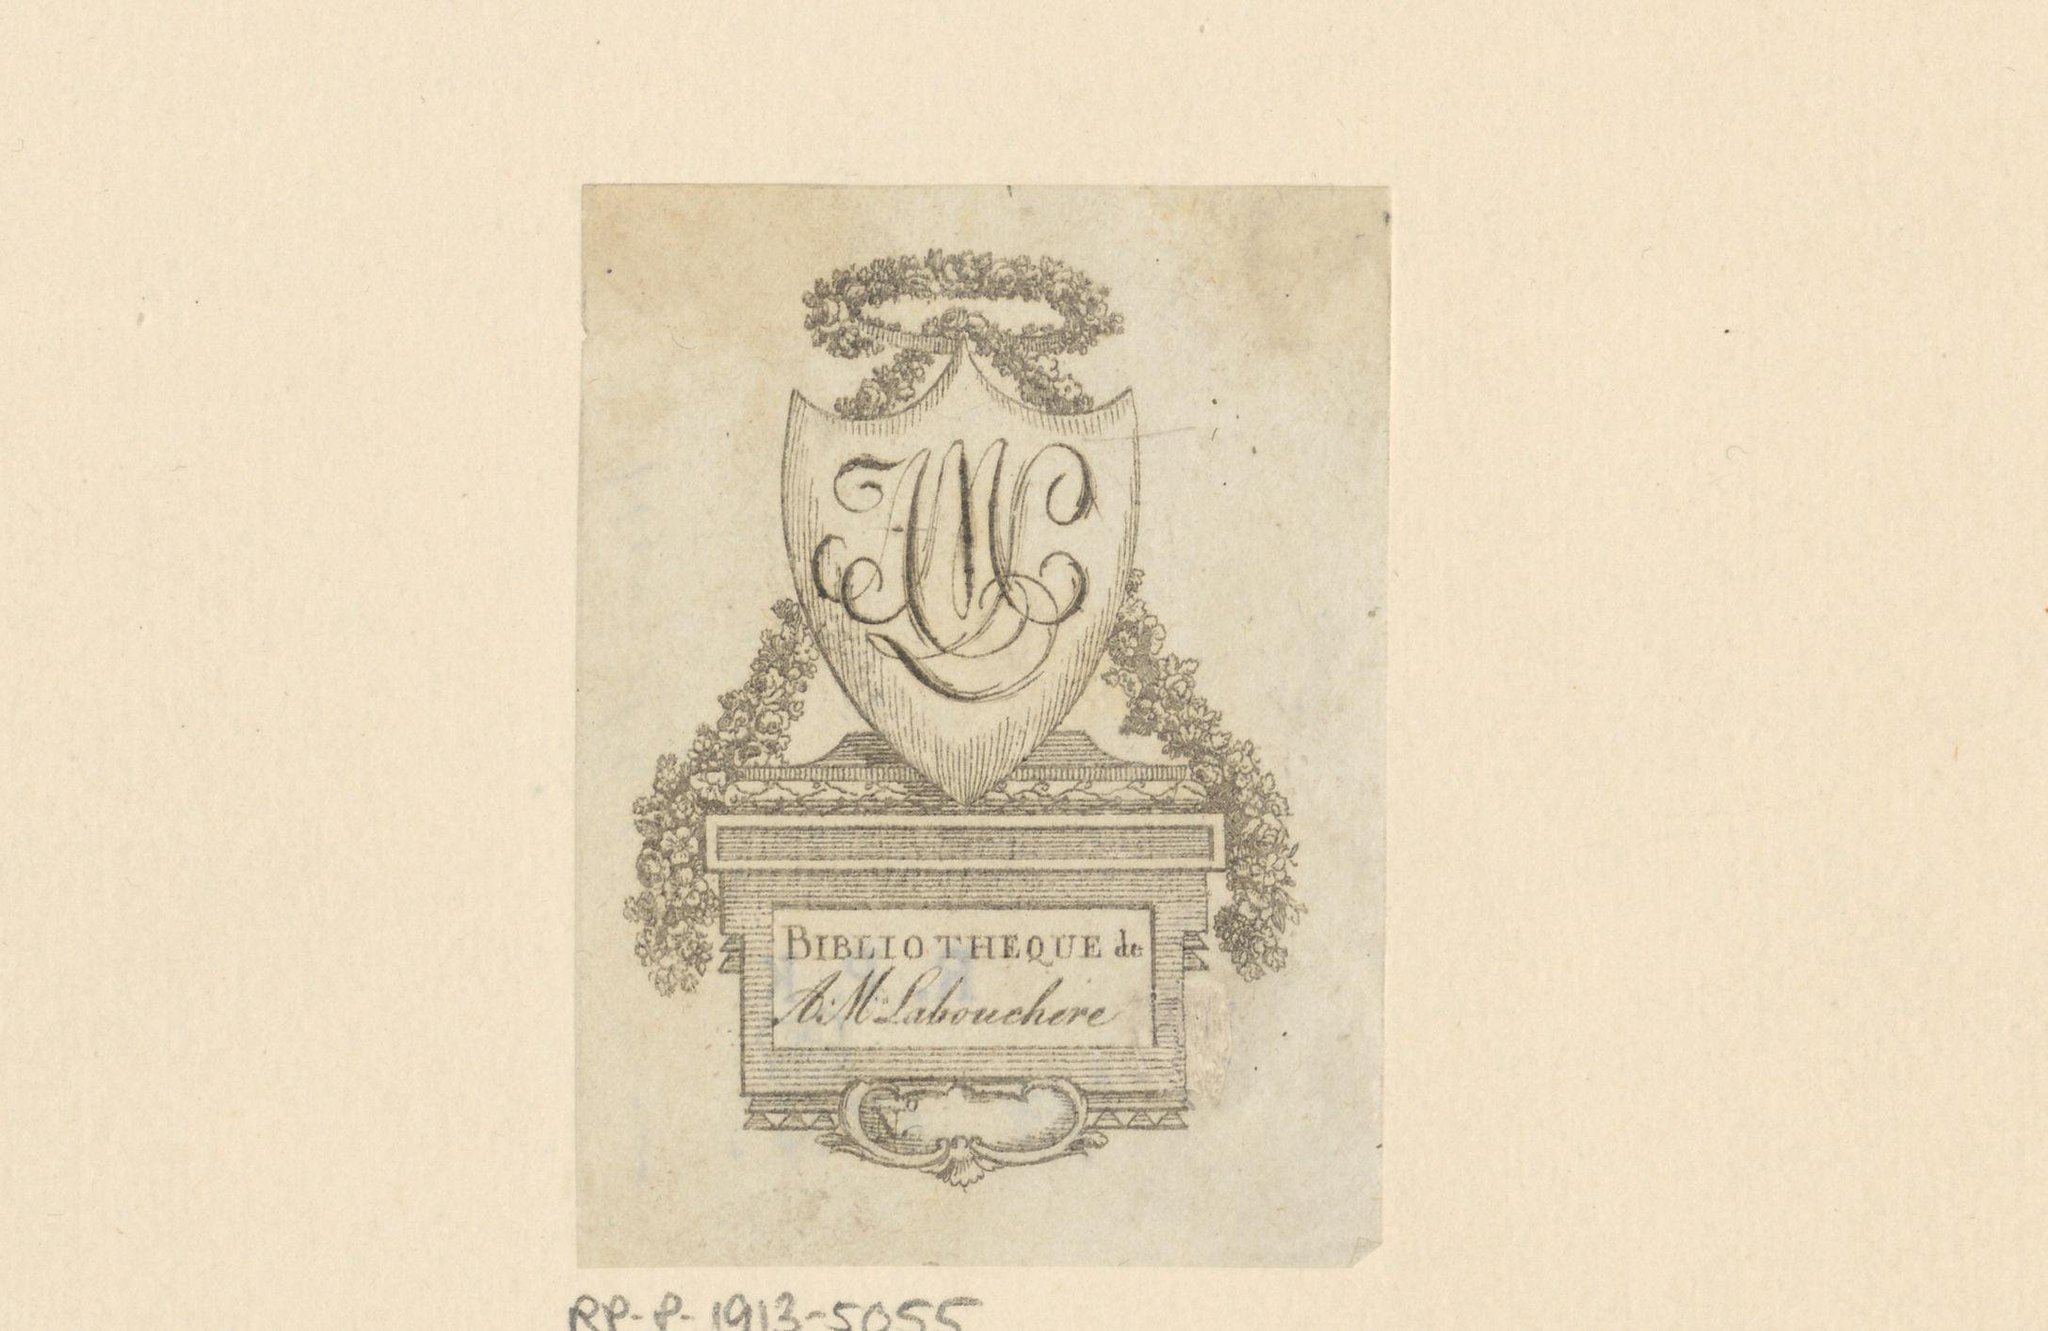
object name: bookplate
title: Ex libris van A.M. Labouchere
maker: Anonymous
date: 1750-1849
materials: paper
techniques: etching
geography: netherlands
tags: garland, wreath, armorial bearing, heraldry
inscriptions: collector's mark: Lugt, collector's mark: Lugt 2233